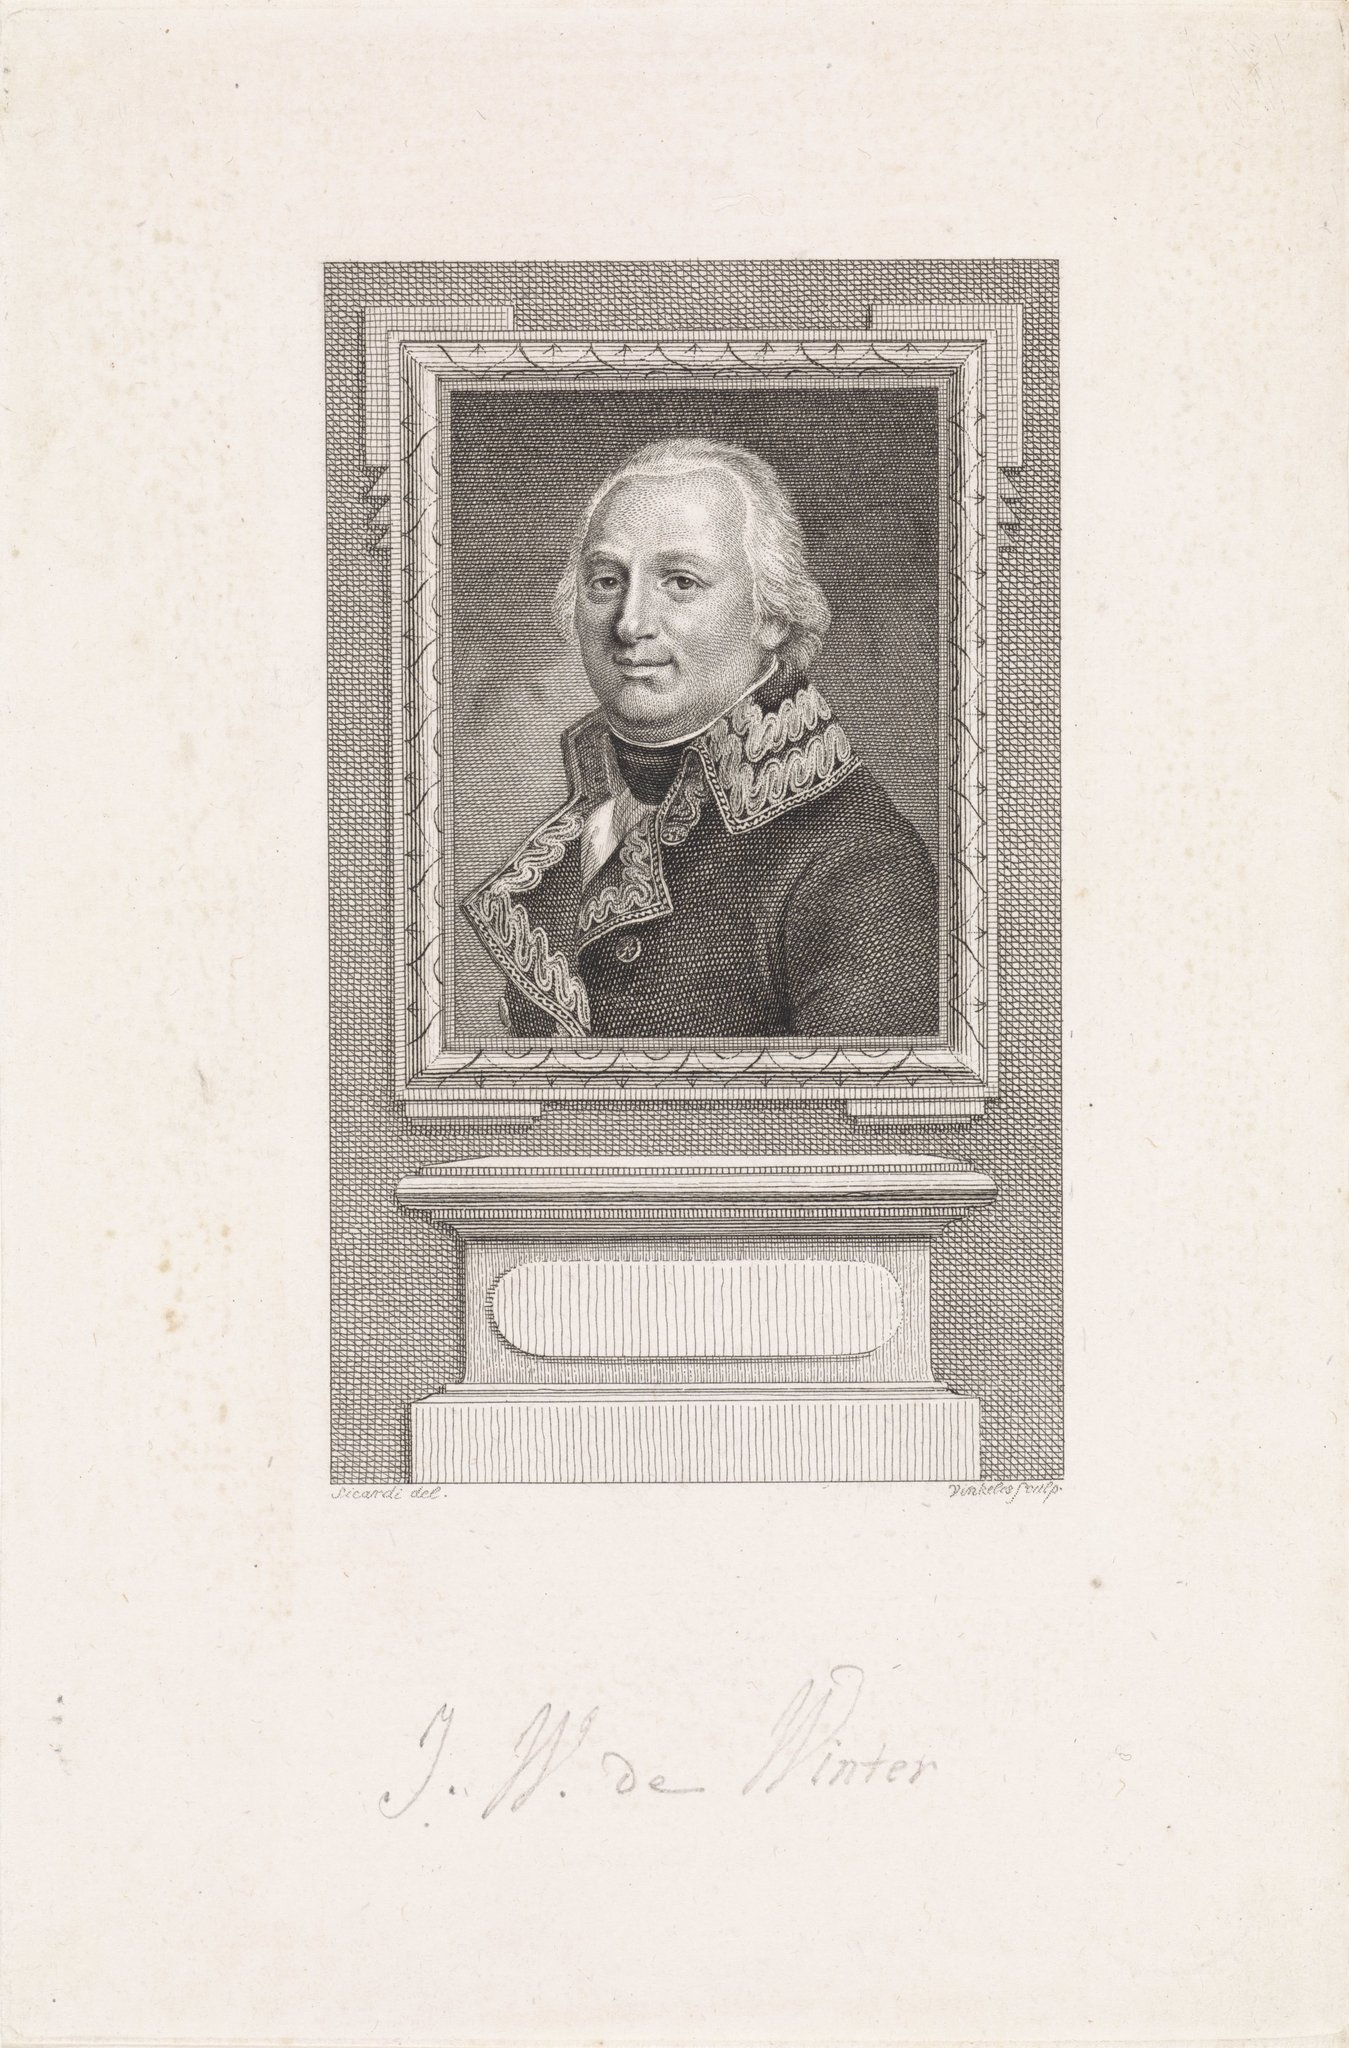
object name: print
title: Portret van Jan Willem de Winter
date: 1786-1809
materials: paper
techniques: engraving, etching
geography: amsterdam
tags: paris, jan willem de winter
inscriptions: collector's mark: Lugt 240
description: Latere staat prent ook gebruikt als boekillustratie in: Wagenaar, Jan. Vaderlandsche historie, (...) ten vervolge van Wagenaars Vaderlandsche historie. Dl. 1-43. Amsterdam: Johannes Allart, 1786-1809.